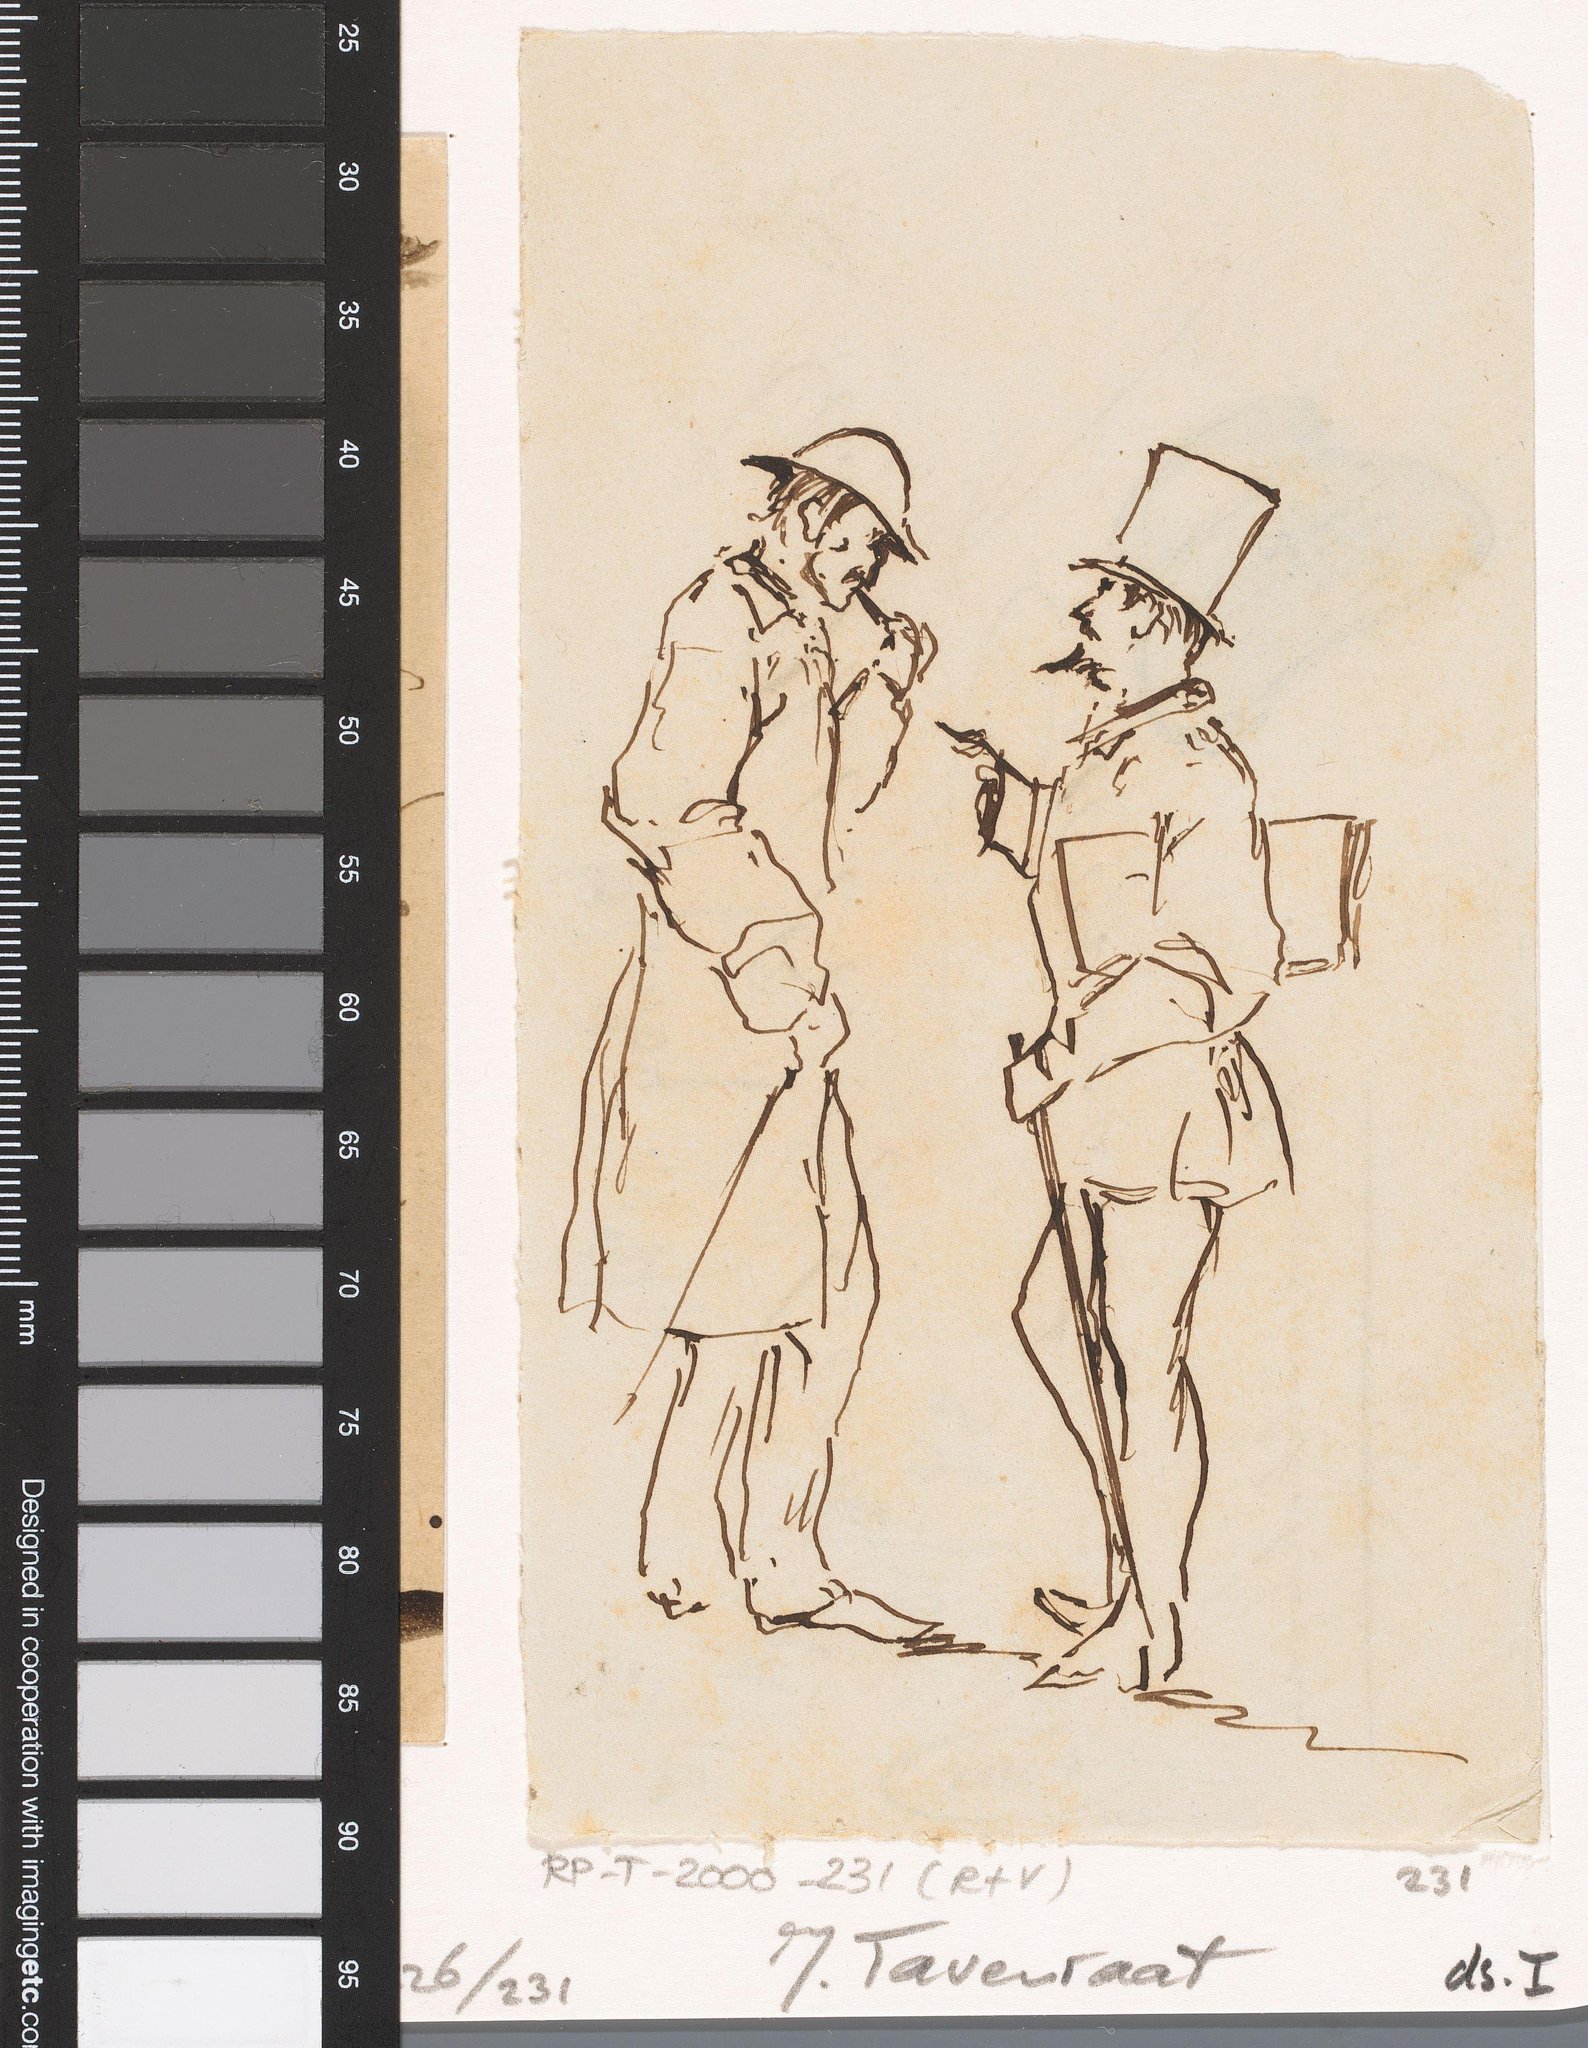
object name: drawing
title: Twee mannen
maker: johannes tavenraat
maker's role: draughtsman, painter, print maker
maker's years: 1809-1881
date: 1840-1880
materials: ink, paper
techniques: pen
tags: standing figure, walking-stick, staff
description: Twee mannen met wandelstokken, met elkaar in gesprek. Op de achterzijde van een fragment van een brief gericht aan Tavenraat.